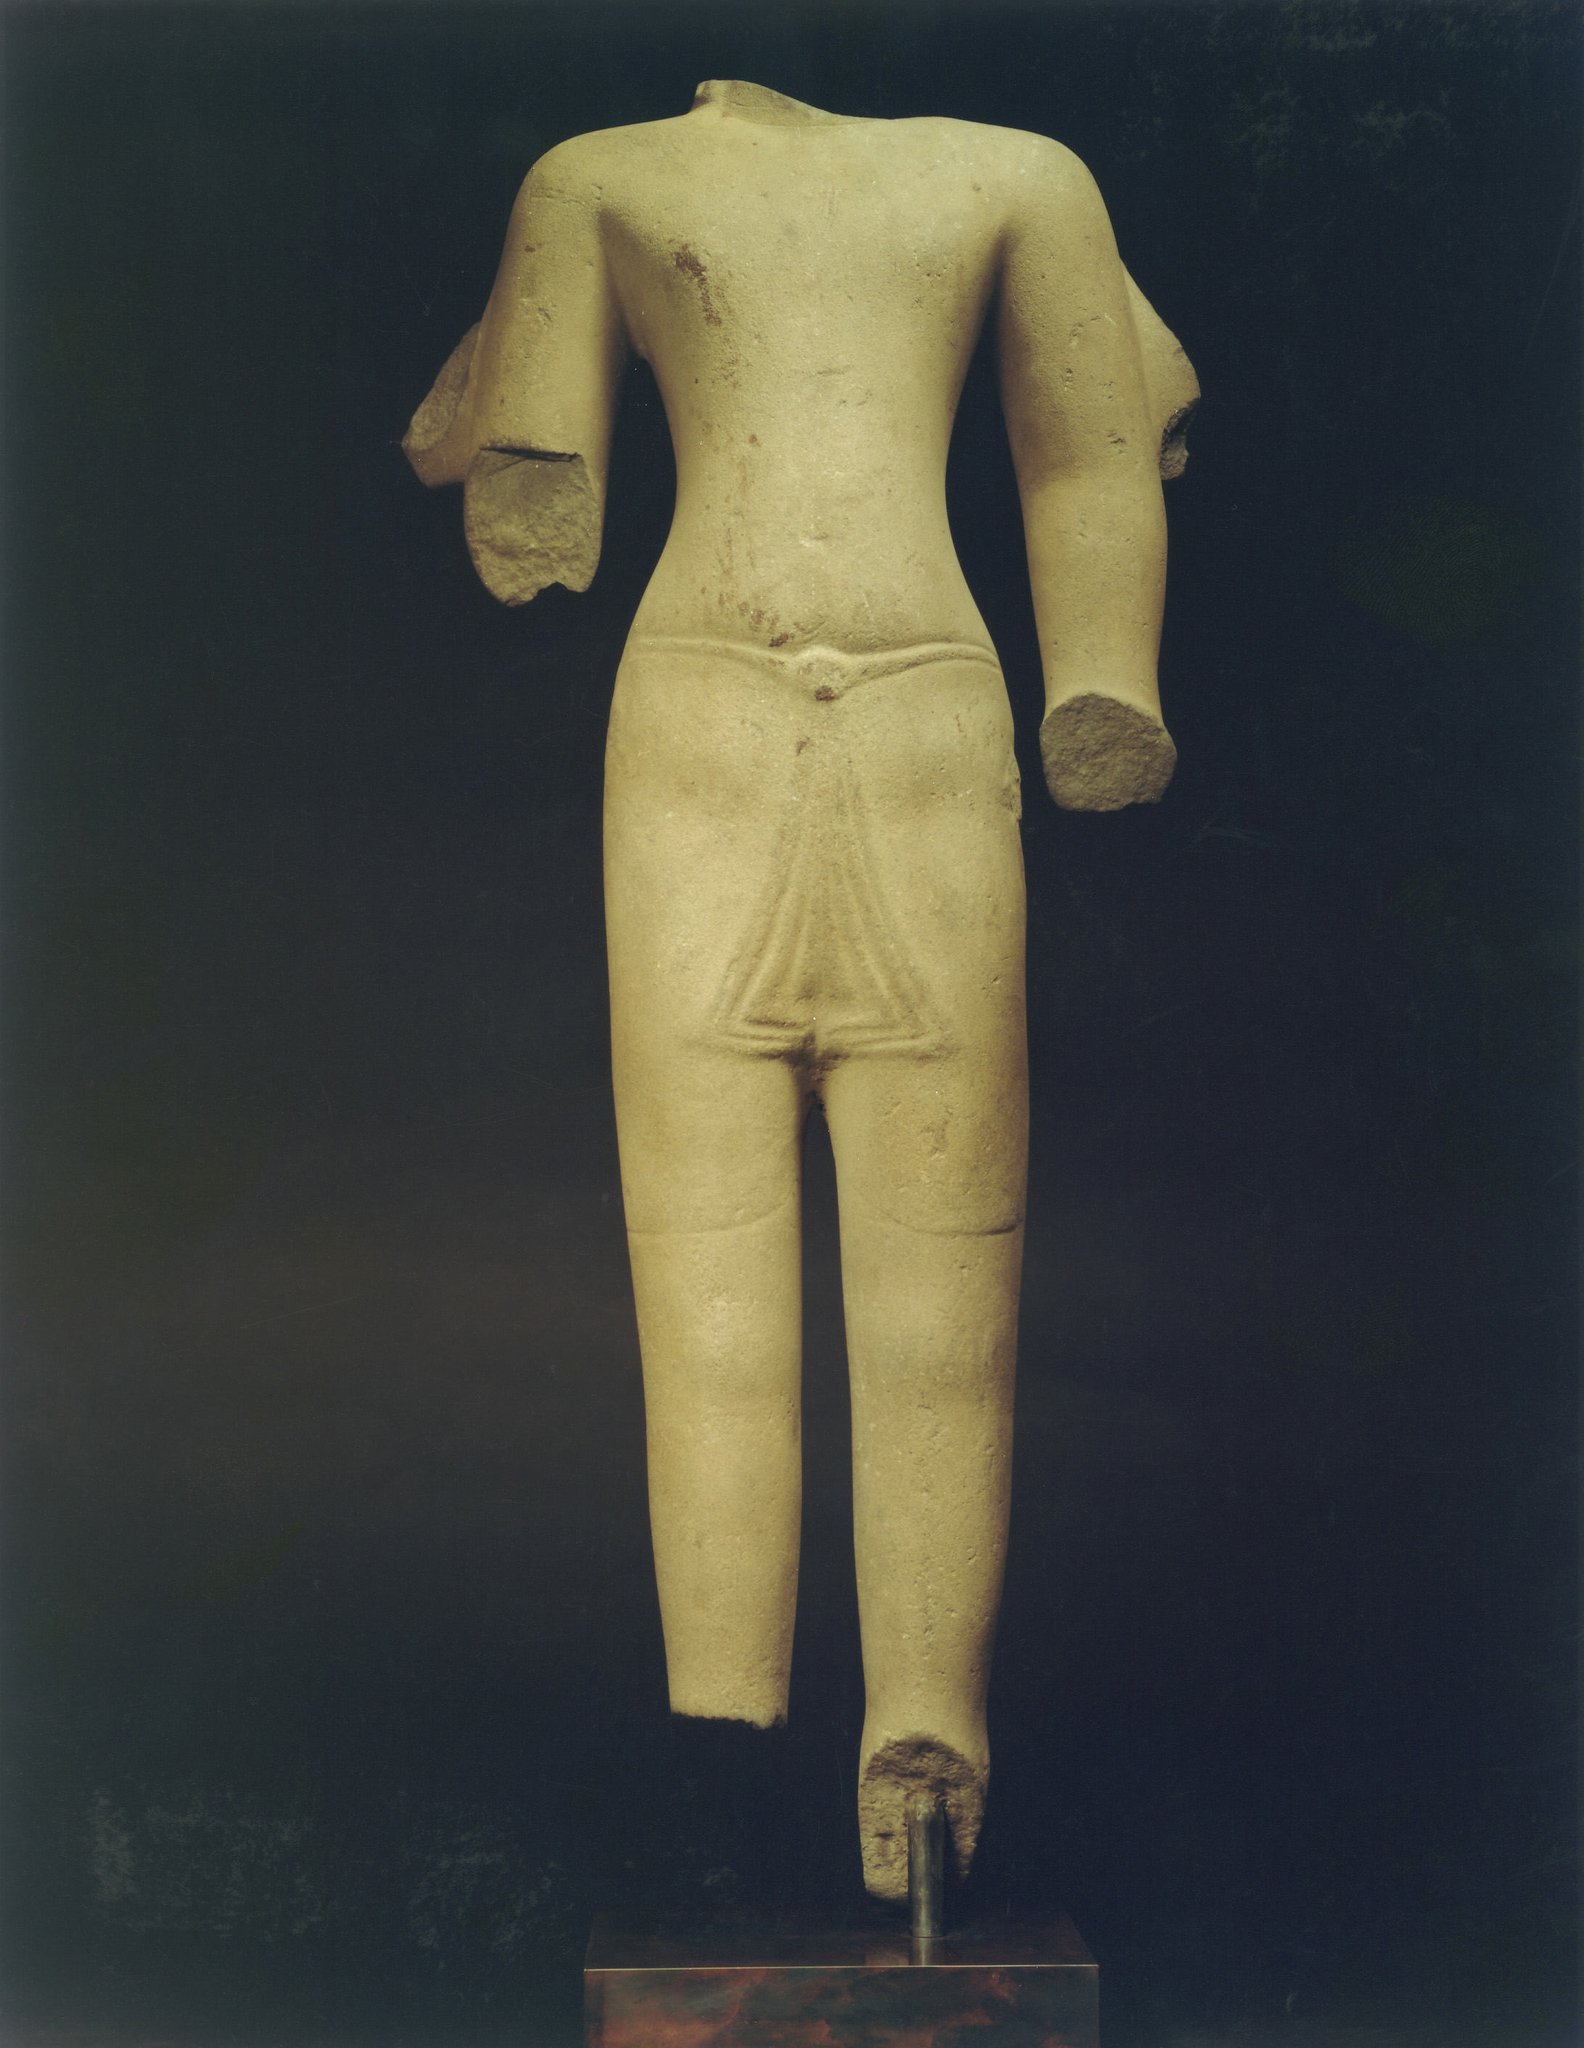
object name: headless figure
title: Standing Four-Armed Male Deity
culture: cambodian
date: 501-600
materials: stone